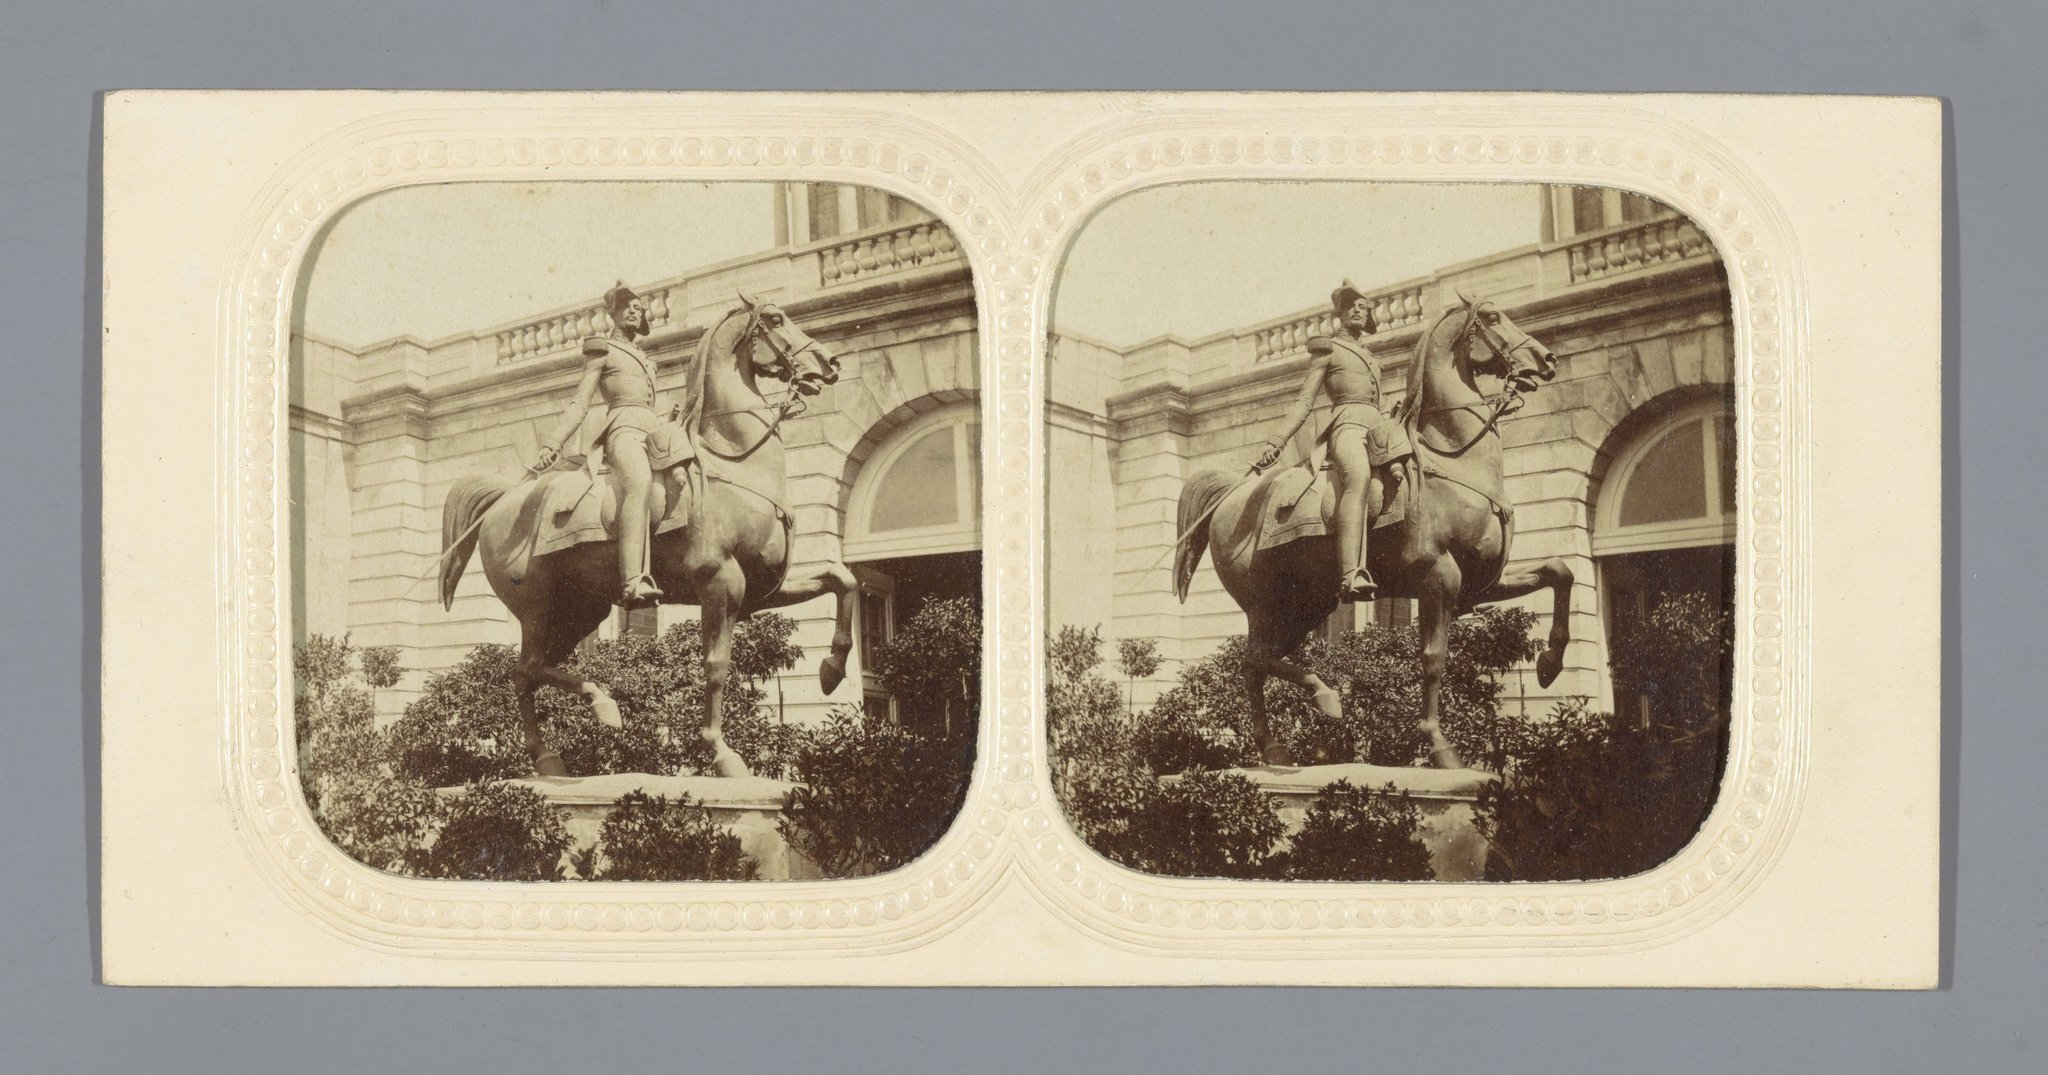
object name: tissue stereograph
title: Ruiterstandbeeld van de hertog van Orléans in Versailles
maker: Anonymous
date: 1855-1875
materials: cardboard, paper, photographic support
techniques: albumen print, hand coloring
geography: versailles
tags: filips ii (hertog van orléans), equestrian statue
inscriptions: inscription: ‘f. 1 Standbeeld van de Hertog van Orleans te Versailles’